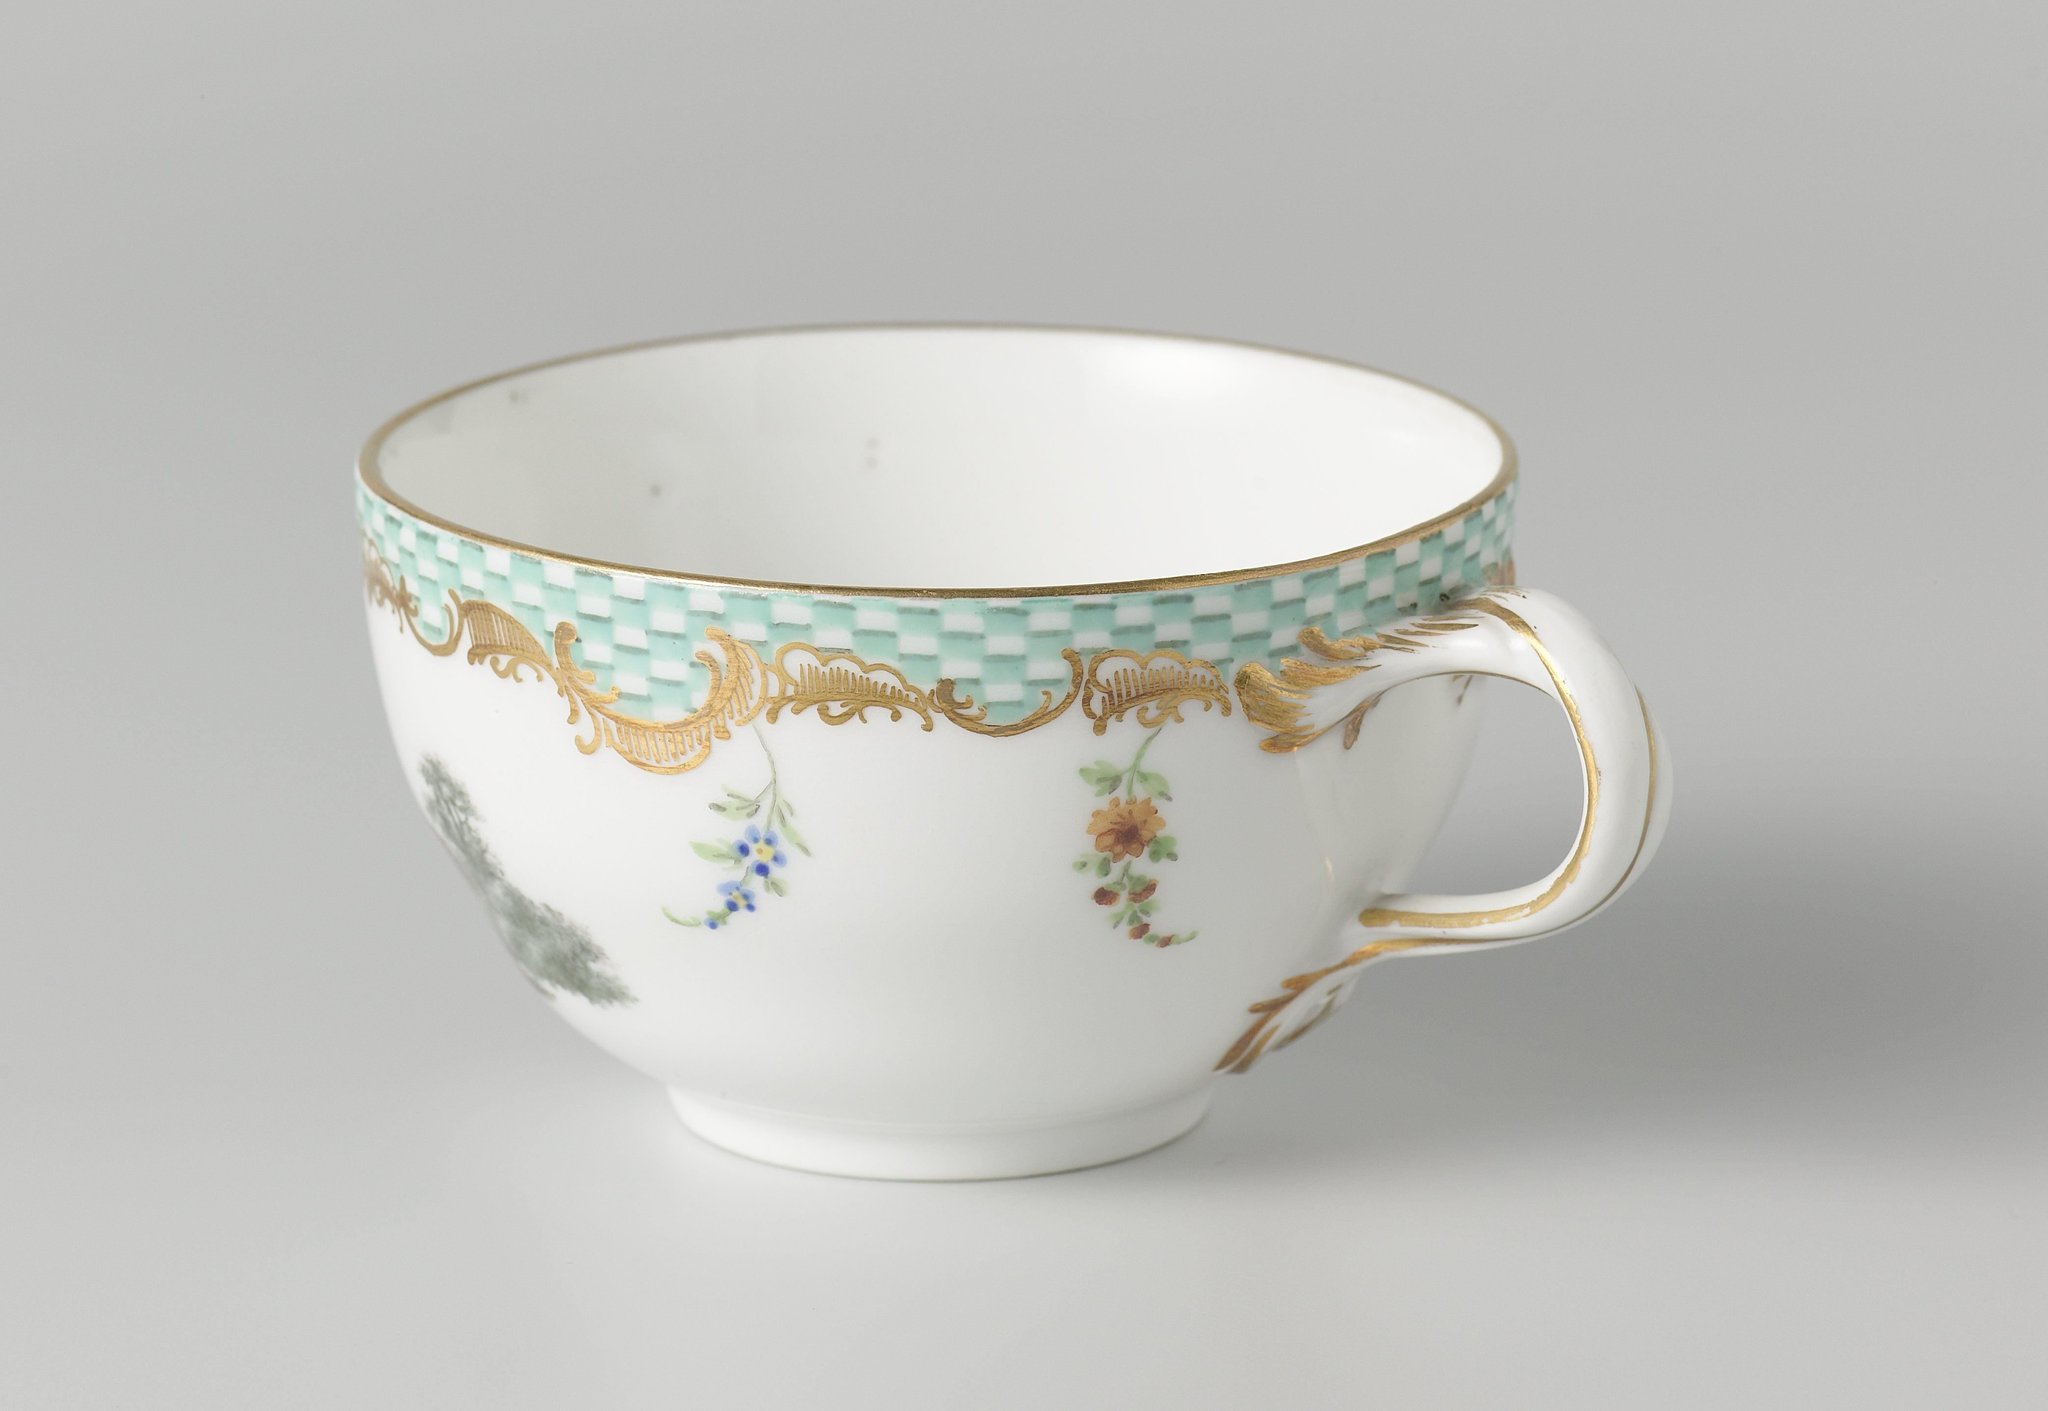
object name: eating drinking utensil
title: Kop, veelkleurig beschilderd met een landschap met figuren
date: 1777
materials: porcelain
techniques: painted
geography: meissen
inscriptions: factory mark, mold mark: ‘18’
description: Lage kop met oor, van beschilderd porselein. De kop is beschilderd met landschappen waarin figuren en langs de rand een brede strook groen vlechtwerk. De kop is gemerkt.